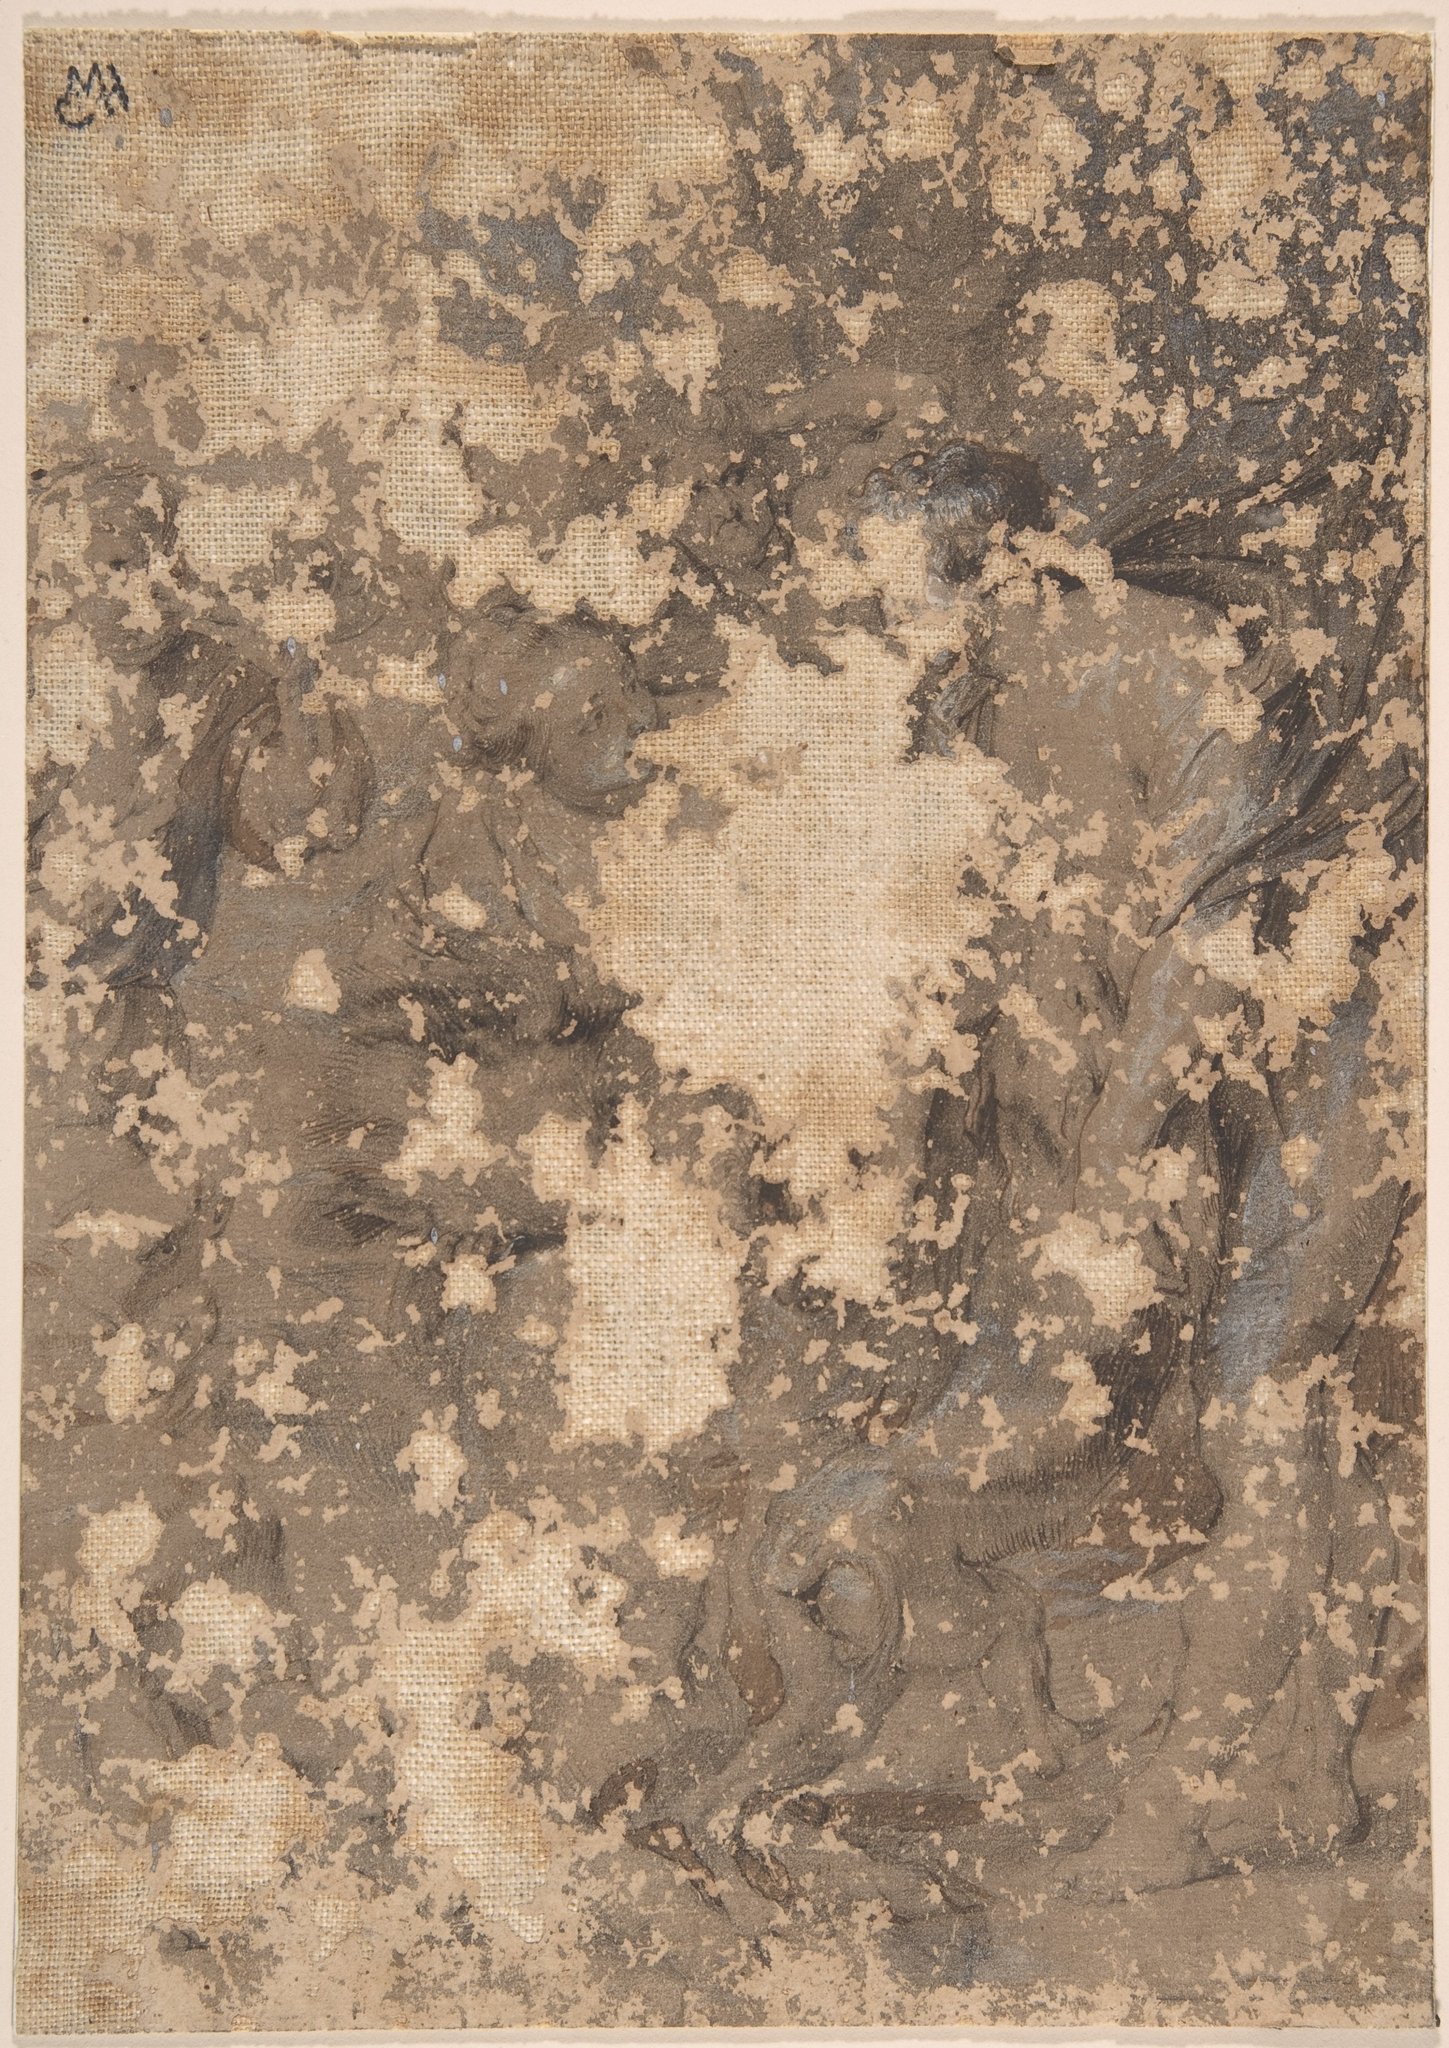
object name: drawing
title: Meleager and Atalanta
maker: abraham van diepenbeeck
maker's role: artist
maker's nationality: flemish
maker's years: 1596-1675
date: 1601-1700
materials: chalk, ink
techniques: brush, heightening, pen